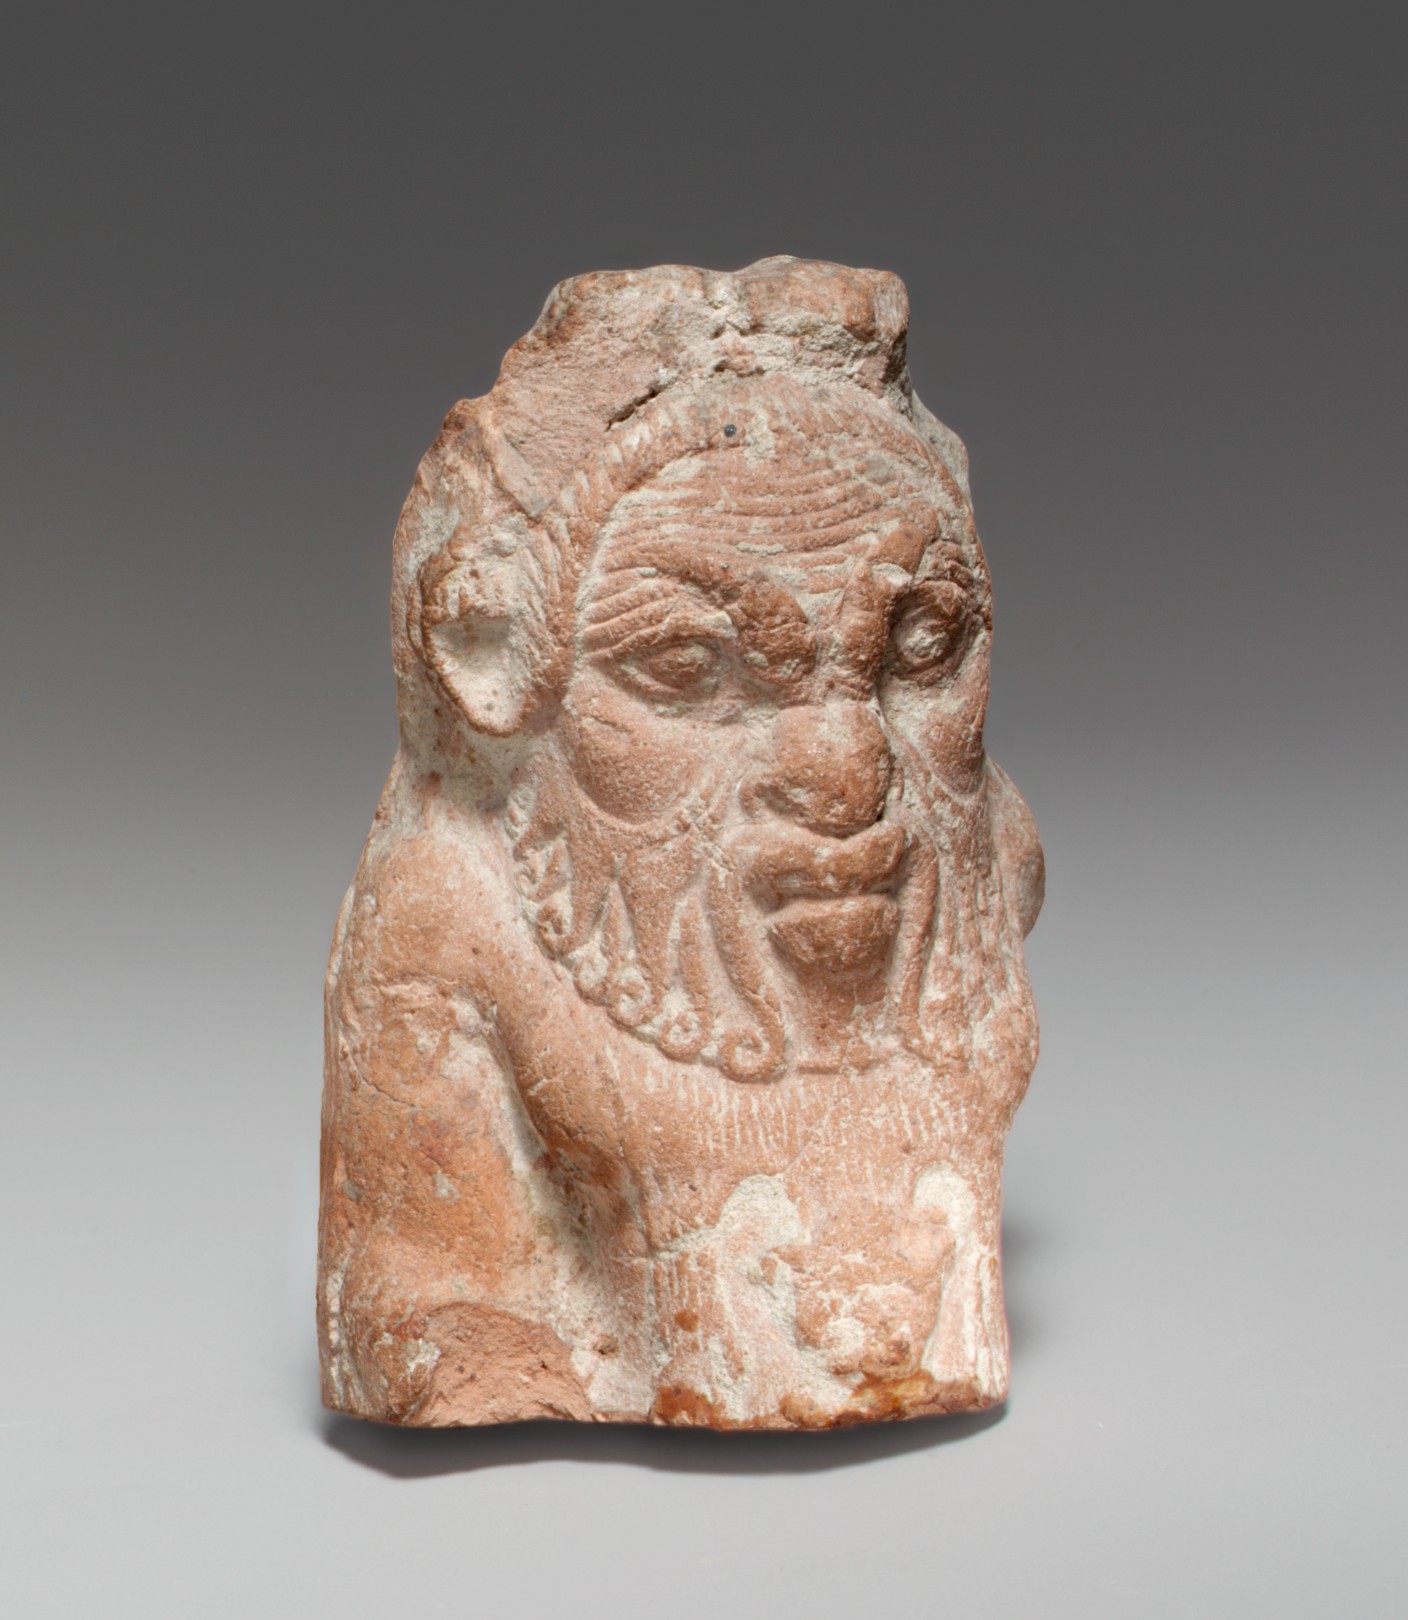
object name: head and torso of be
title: Bes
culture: cypriot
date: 100 BCE-100 CE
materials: terracotta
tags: heads,bes